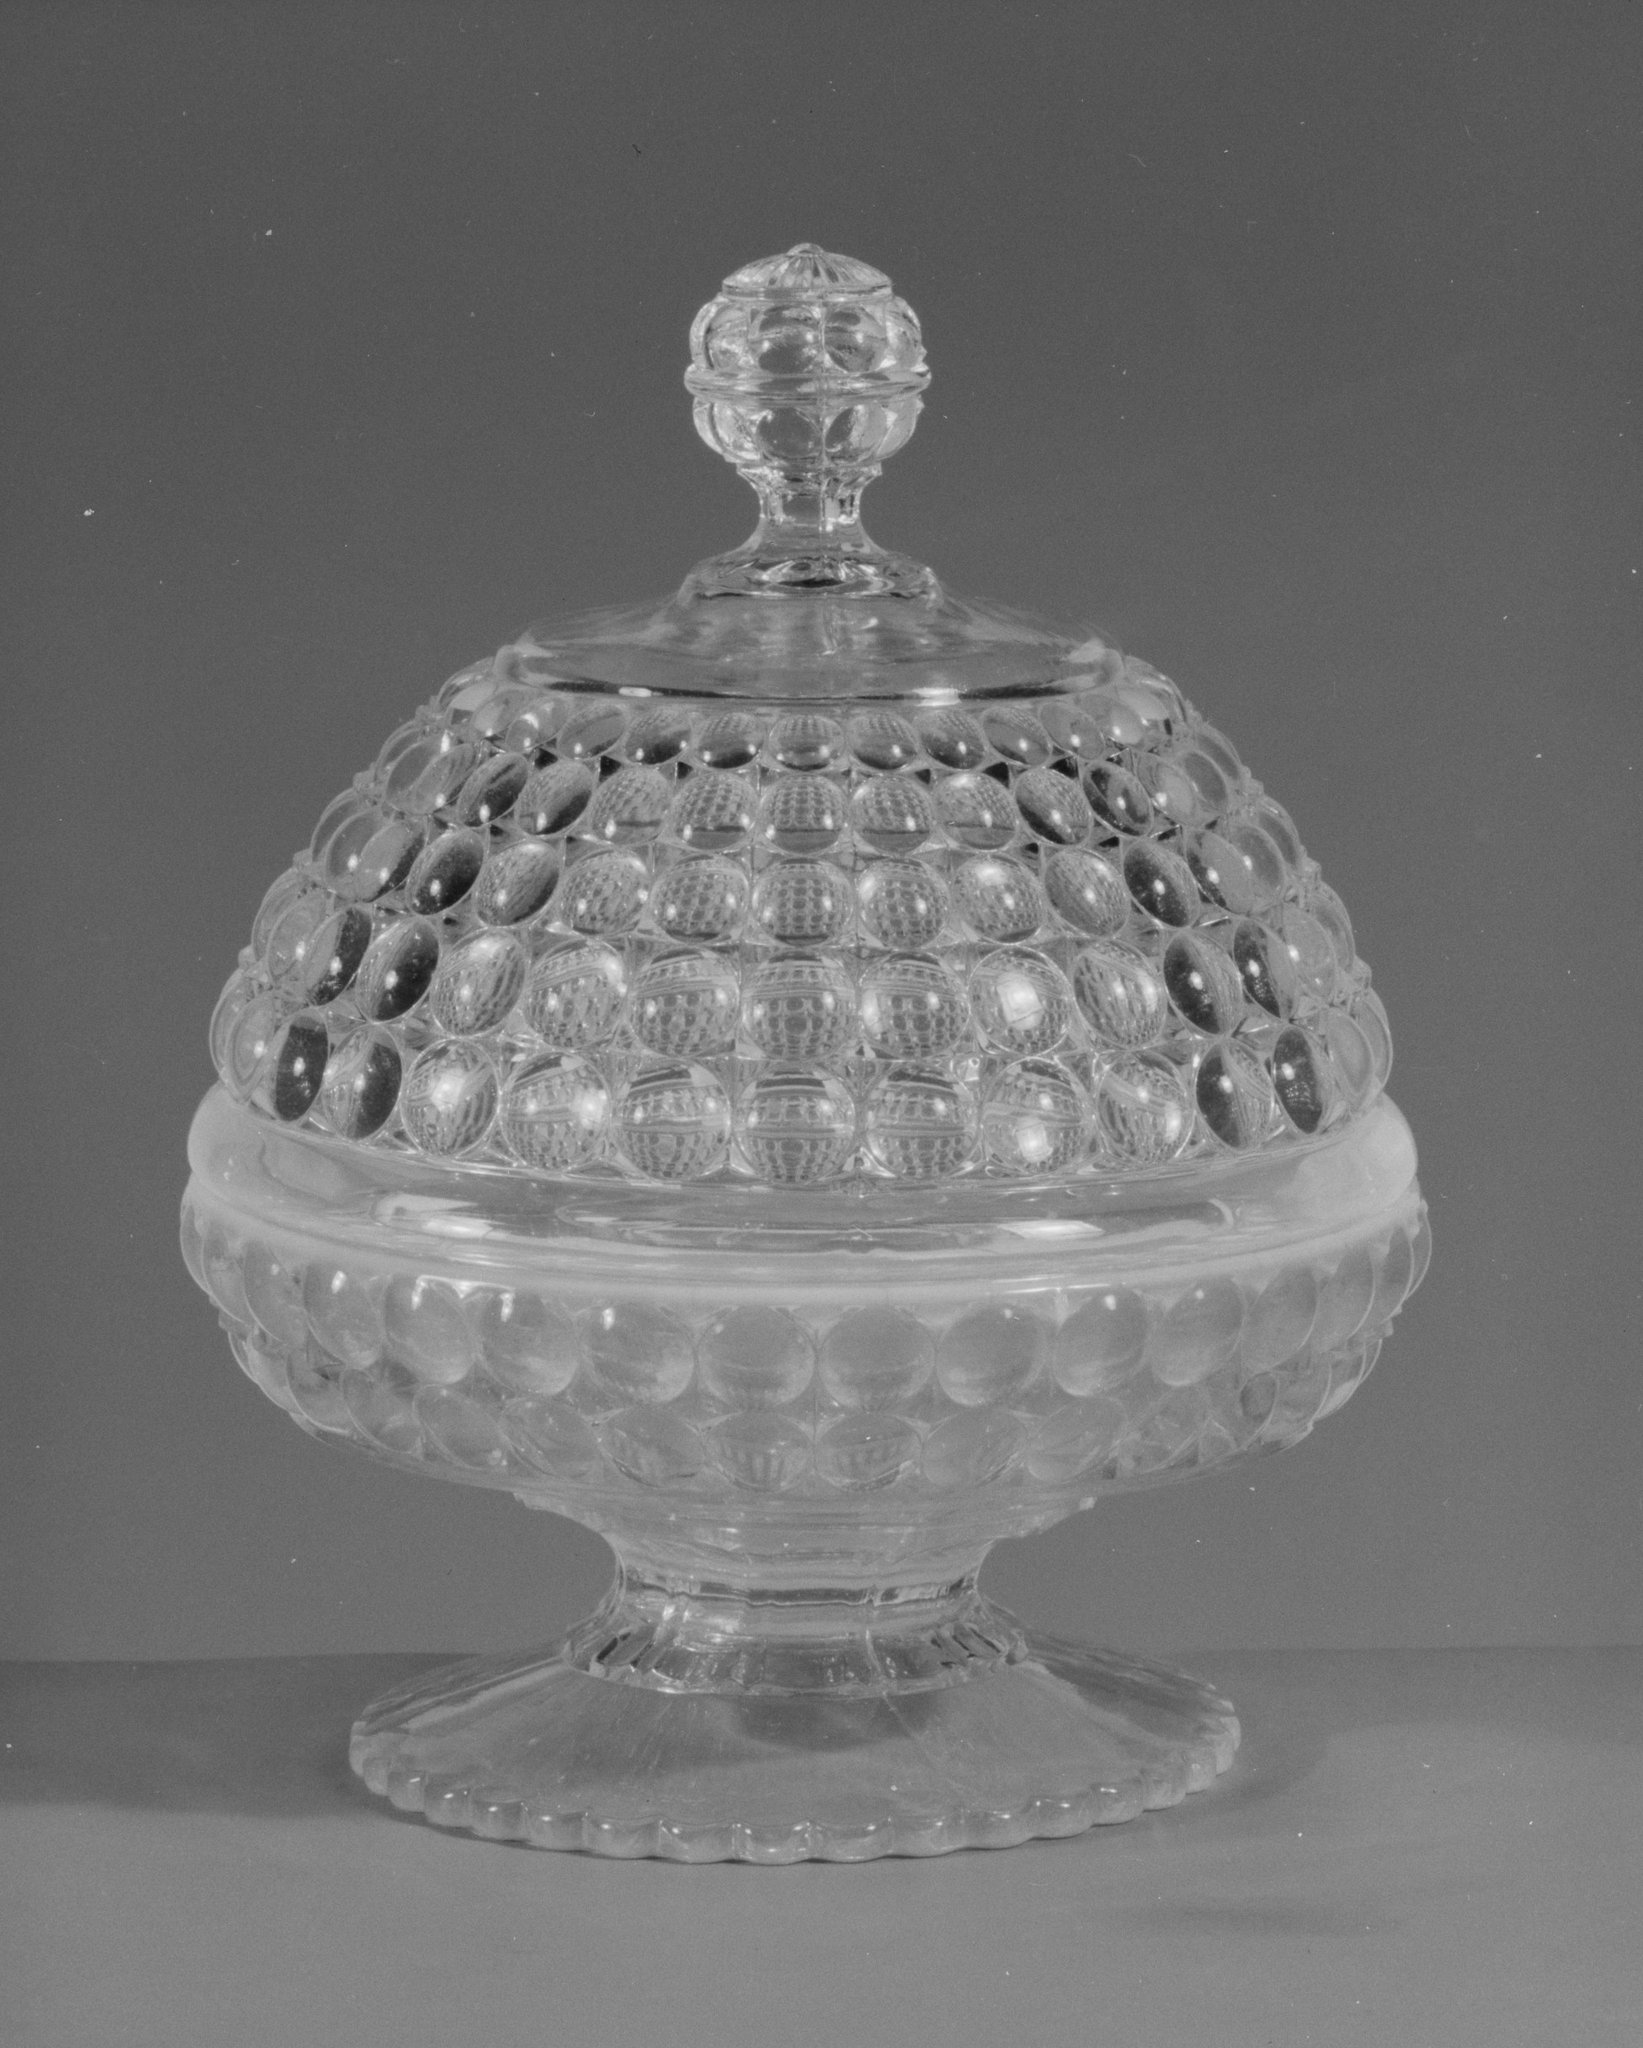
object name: butter dish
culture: american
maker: richards and hartley flint glass co.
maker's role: maker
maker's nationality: american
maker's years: 1867-1890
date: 1888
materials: glass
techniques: pressed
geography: united states